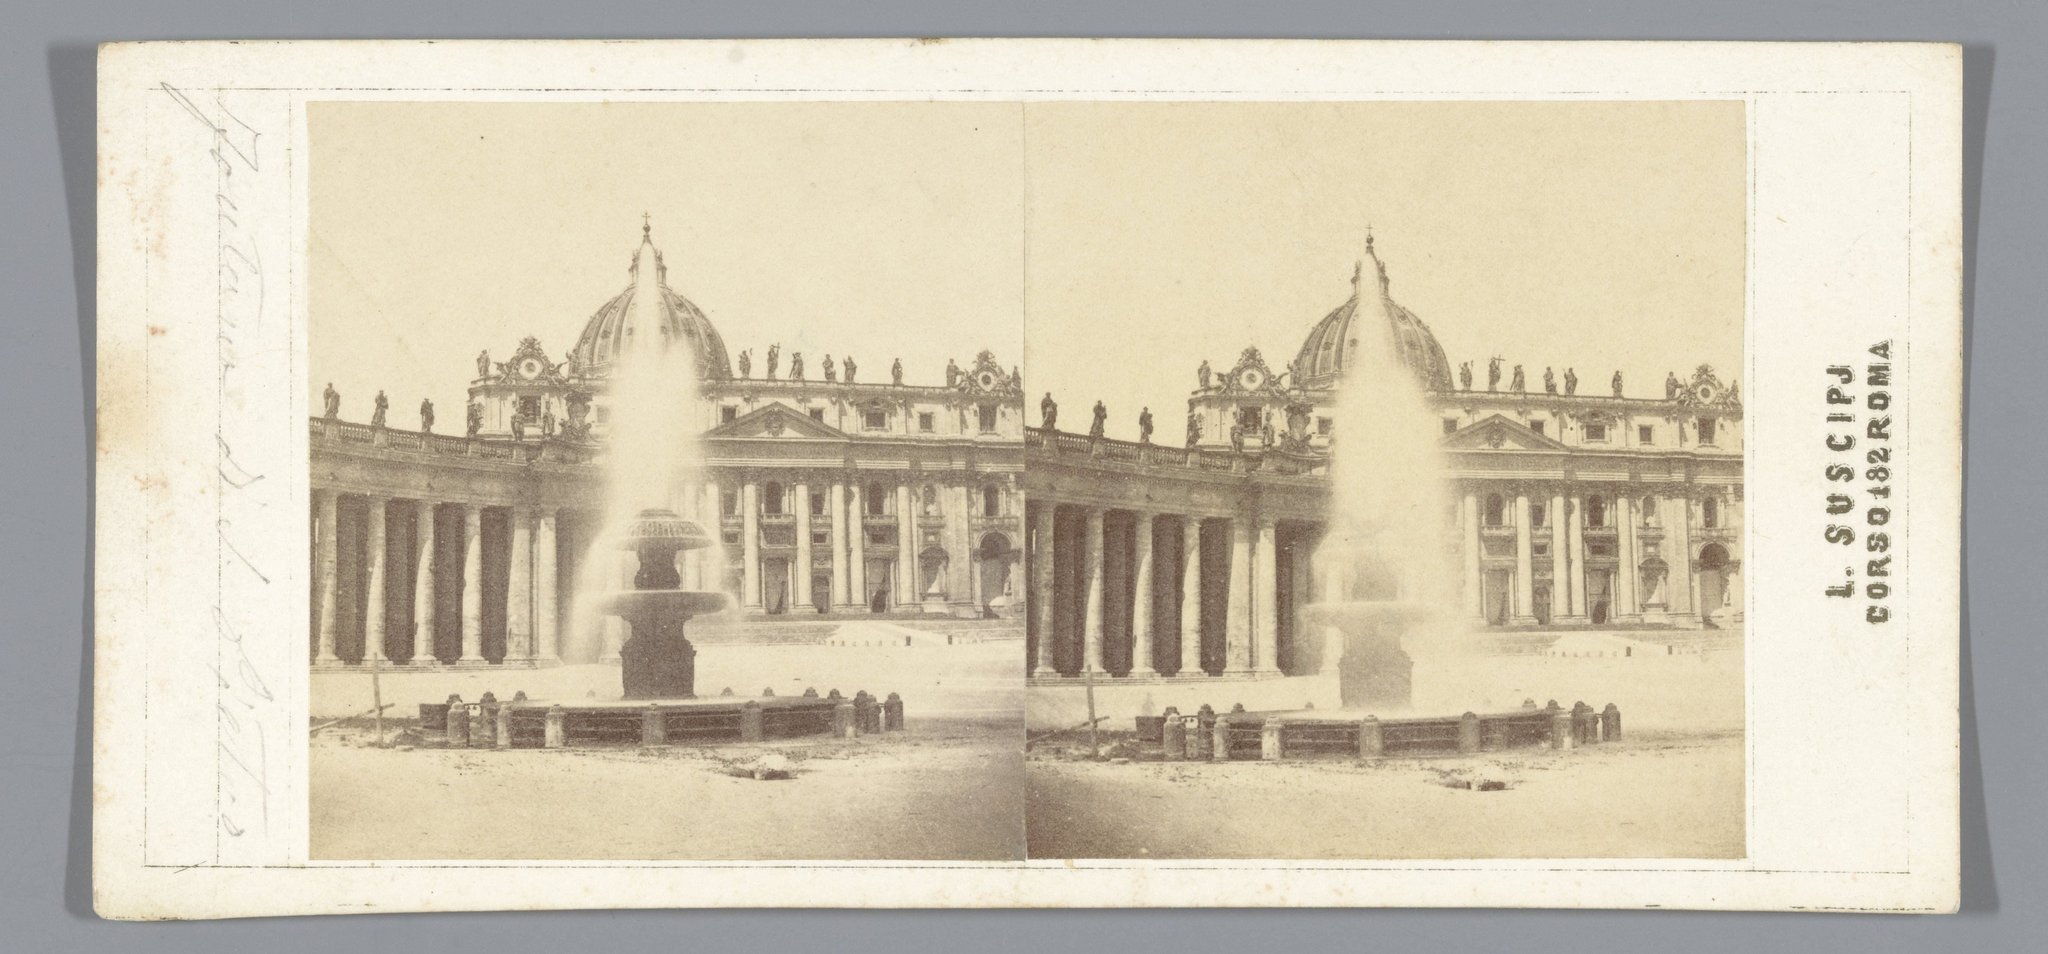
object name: stereograph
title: Gezicht op het Sint-Pietersplein in Vaticaanstad met een fontein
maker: lorenzo suscipi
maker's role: fotograaf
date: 1850-1880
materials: cardboard, photographic support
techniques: albumen print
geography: vatican city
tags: square, place, circus, etc., ornamental fountain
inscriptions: number: ‘N: 5.’